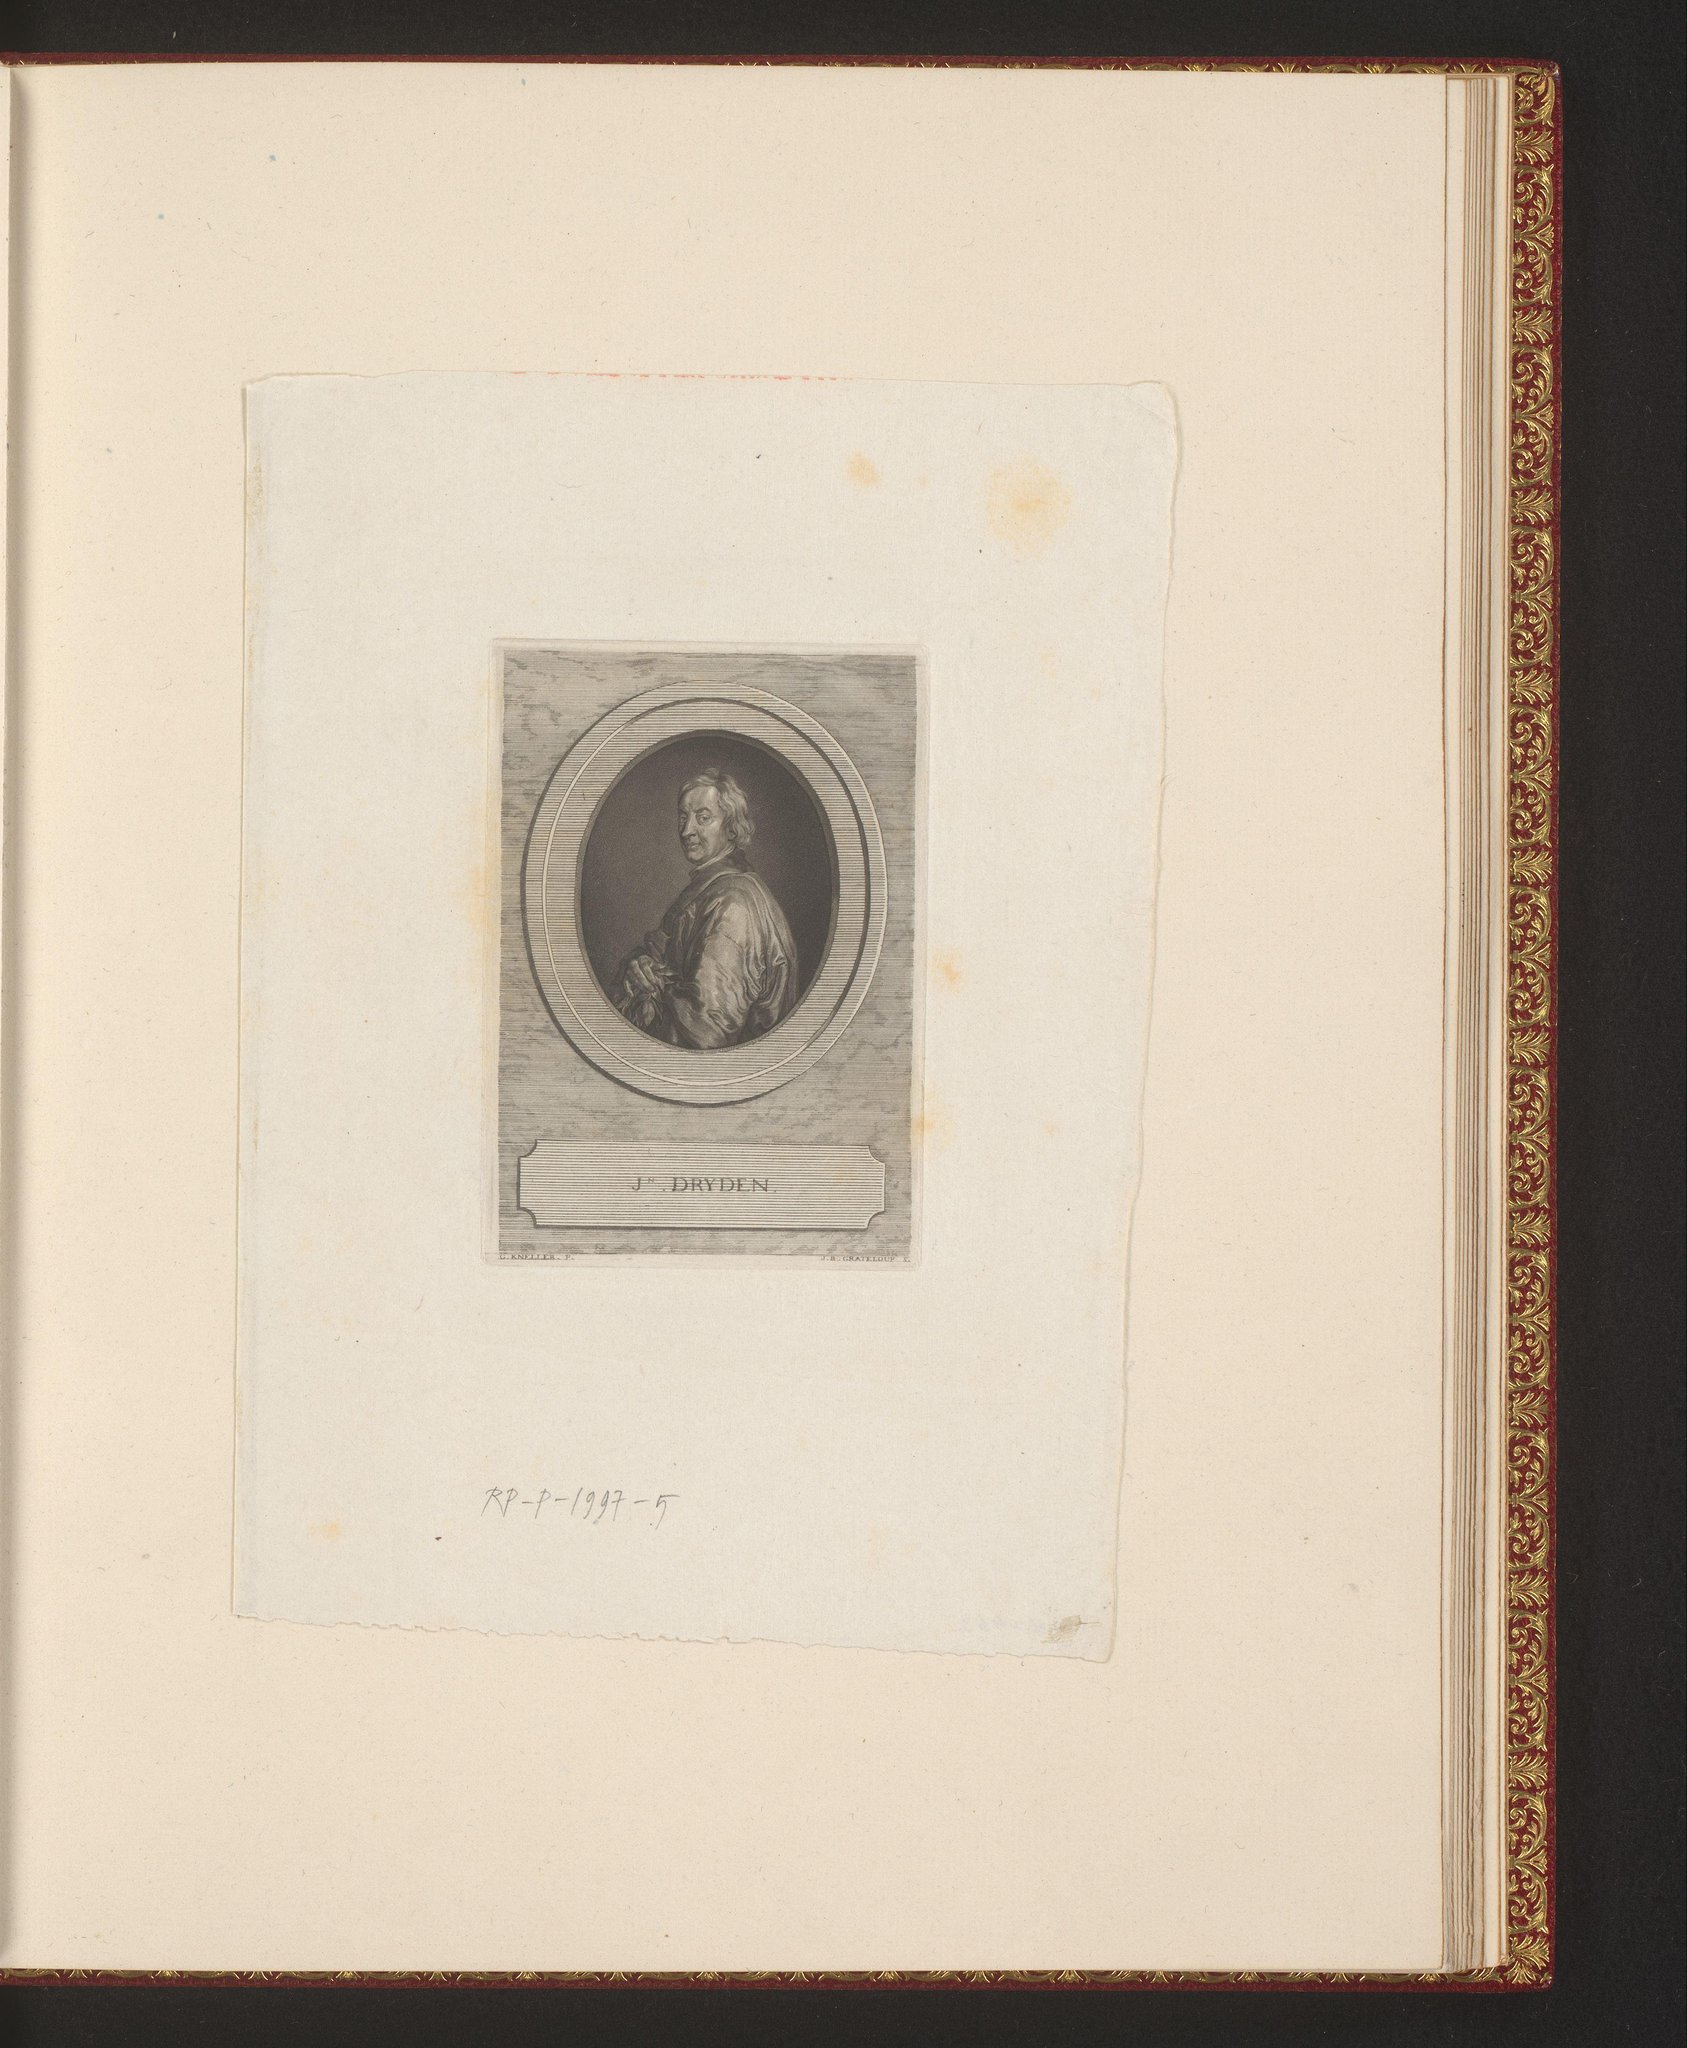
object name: album leaf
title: Jn. Dryden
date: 1765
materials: paper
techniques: aquatint, etching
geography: france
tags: england, london, john dryden, historical persons, writer, poet, author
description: Jean-Baptiste de Grateloup gebruikte een geheim proces bij het maken van zijn prenten, lijkend op aquatint. Zijn neef Jean-Pierre Sylvestre de Grateloup heeft ook op deze manier gewerkt.